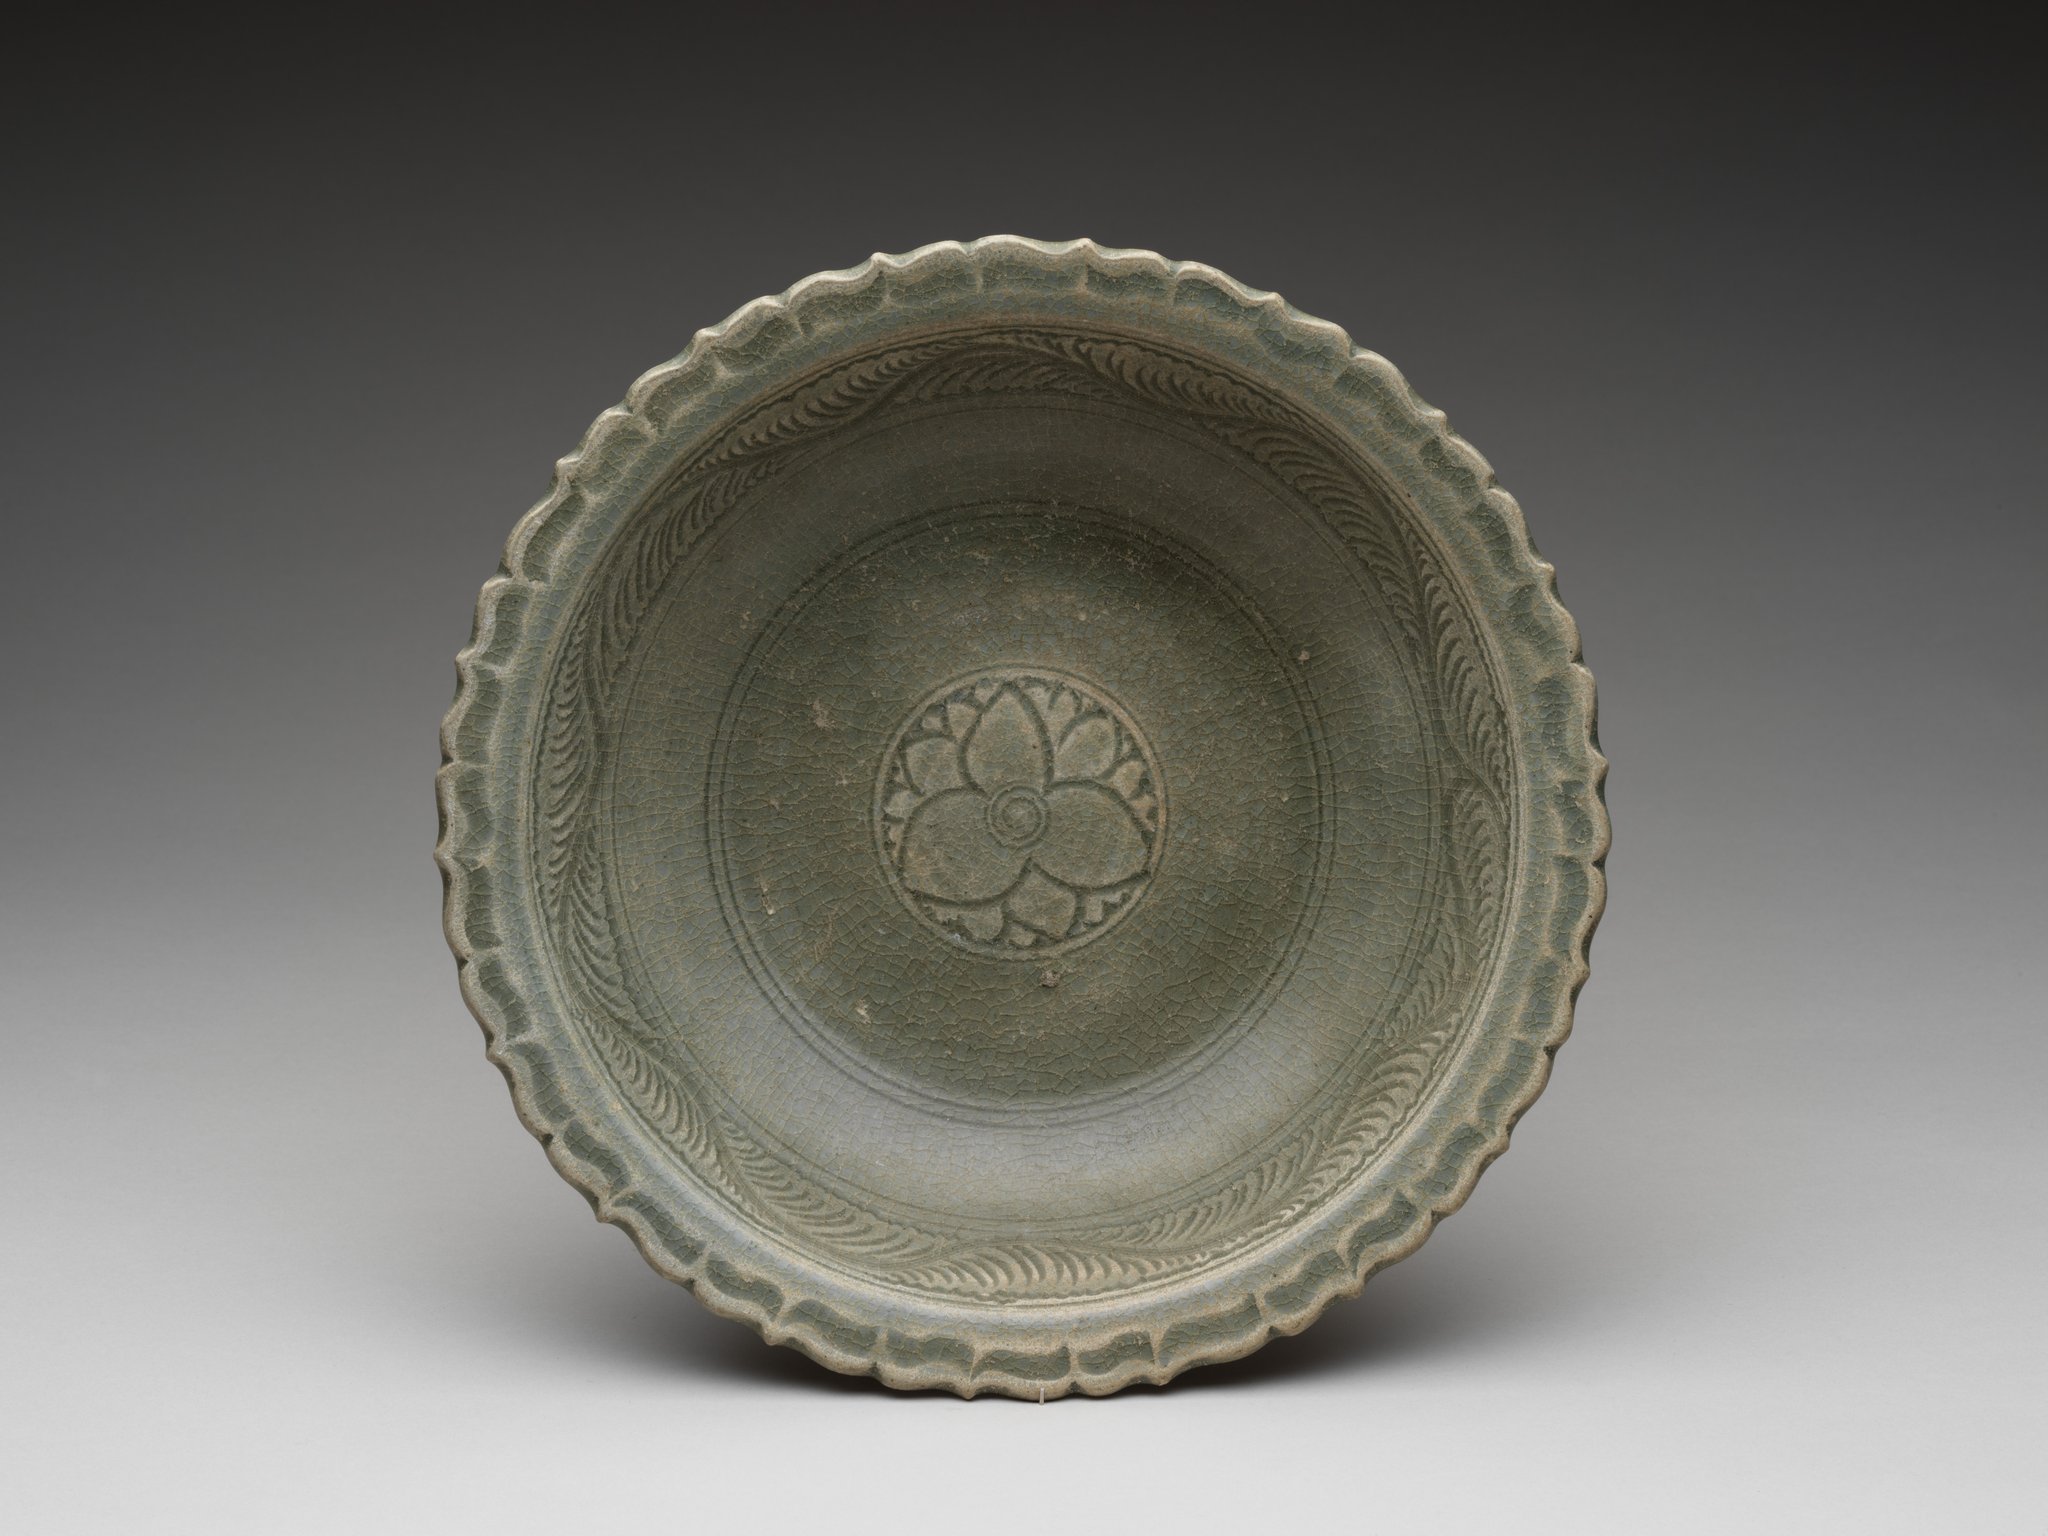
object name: dish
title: Dish green glazed with floral medallion and foliate rim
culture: north-central thai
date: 1401-1600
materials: glaze, iron, stoneware